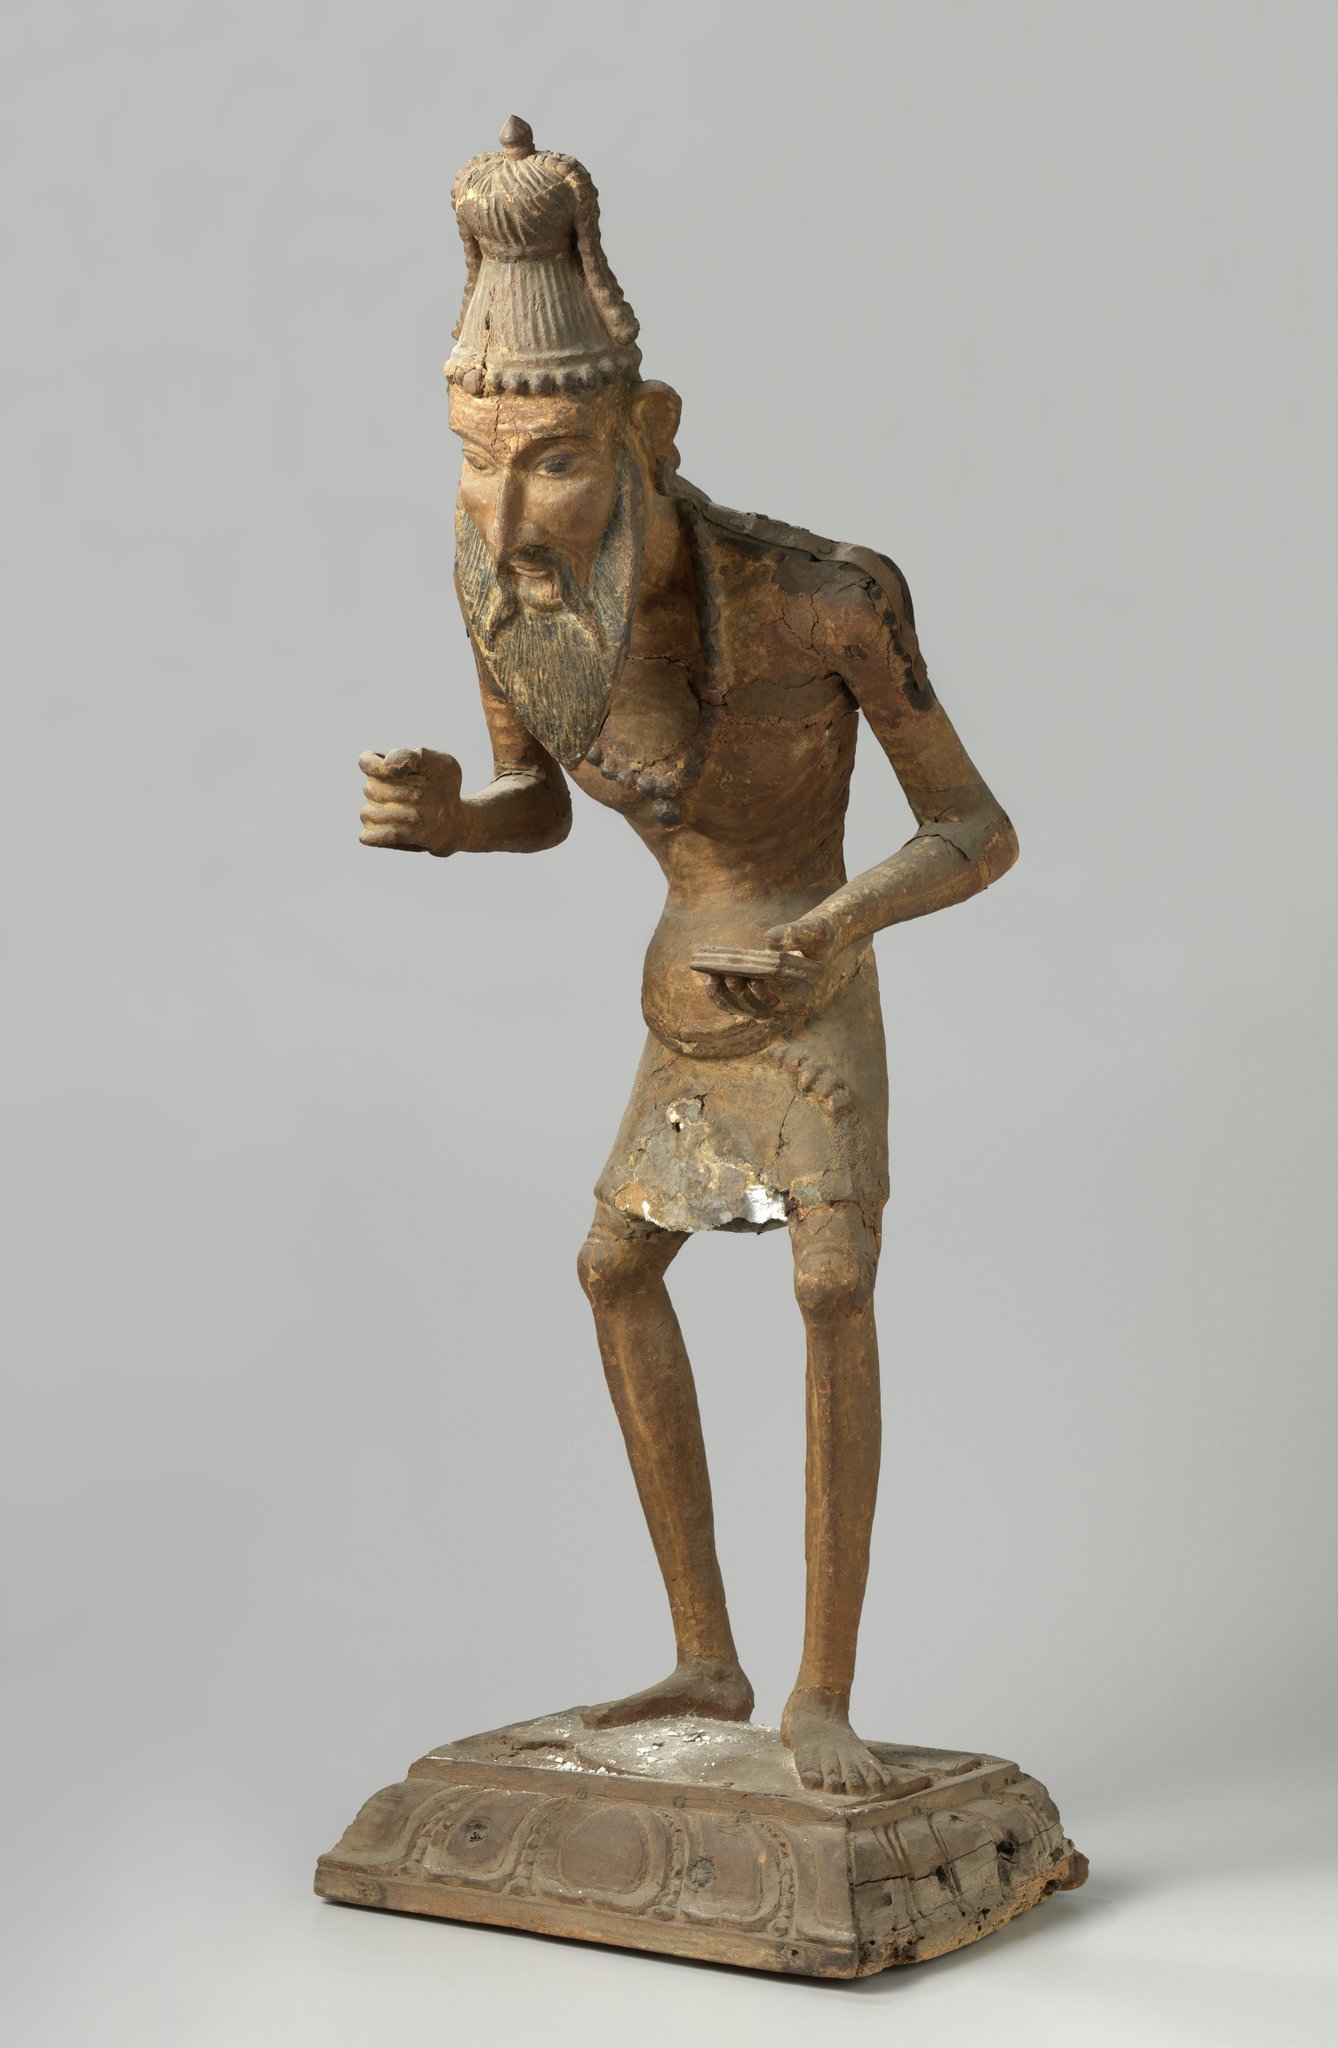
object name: figure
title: Bhringi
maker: Anonymous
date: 1700-1800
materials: dye, wood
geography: india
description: De wijsgeer (rishi) Bhringi met drie benen; het derde is verwijderd.